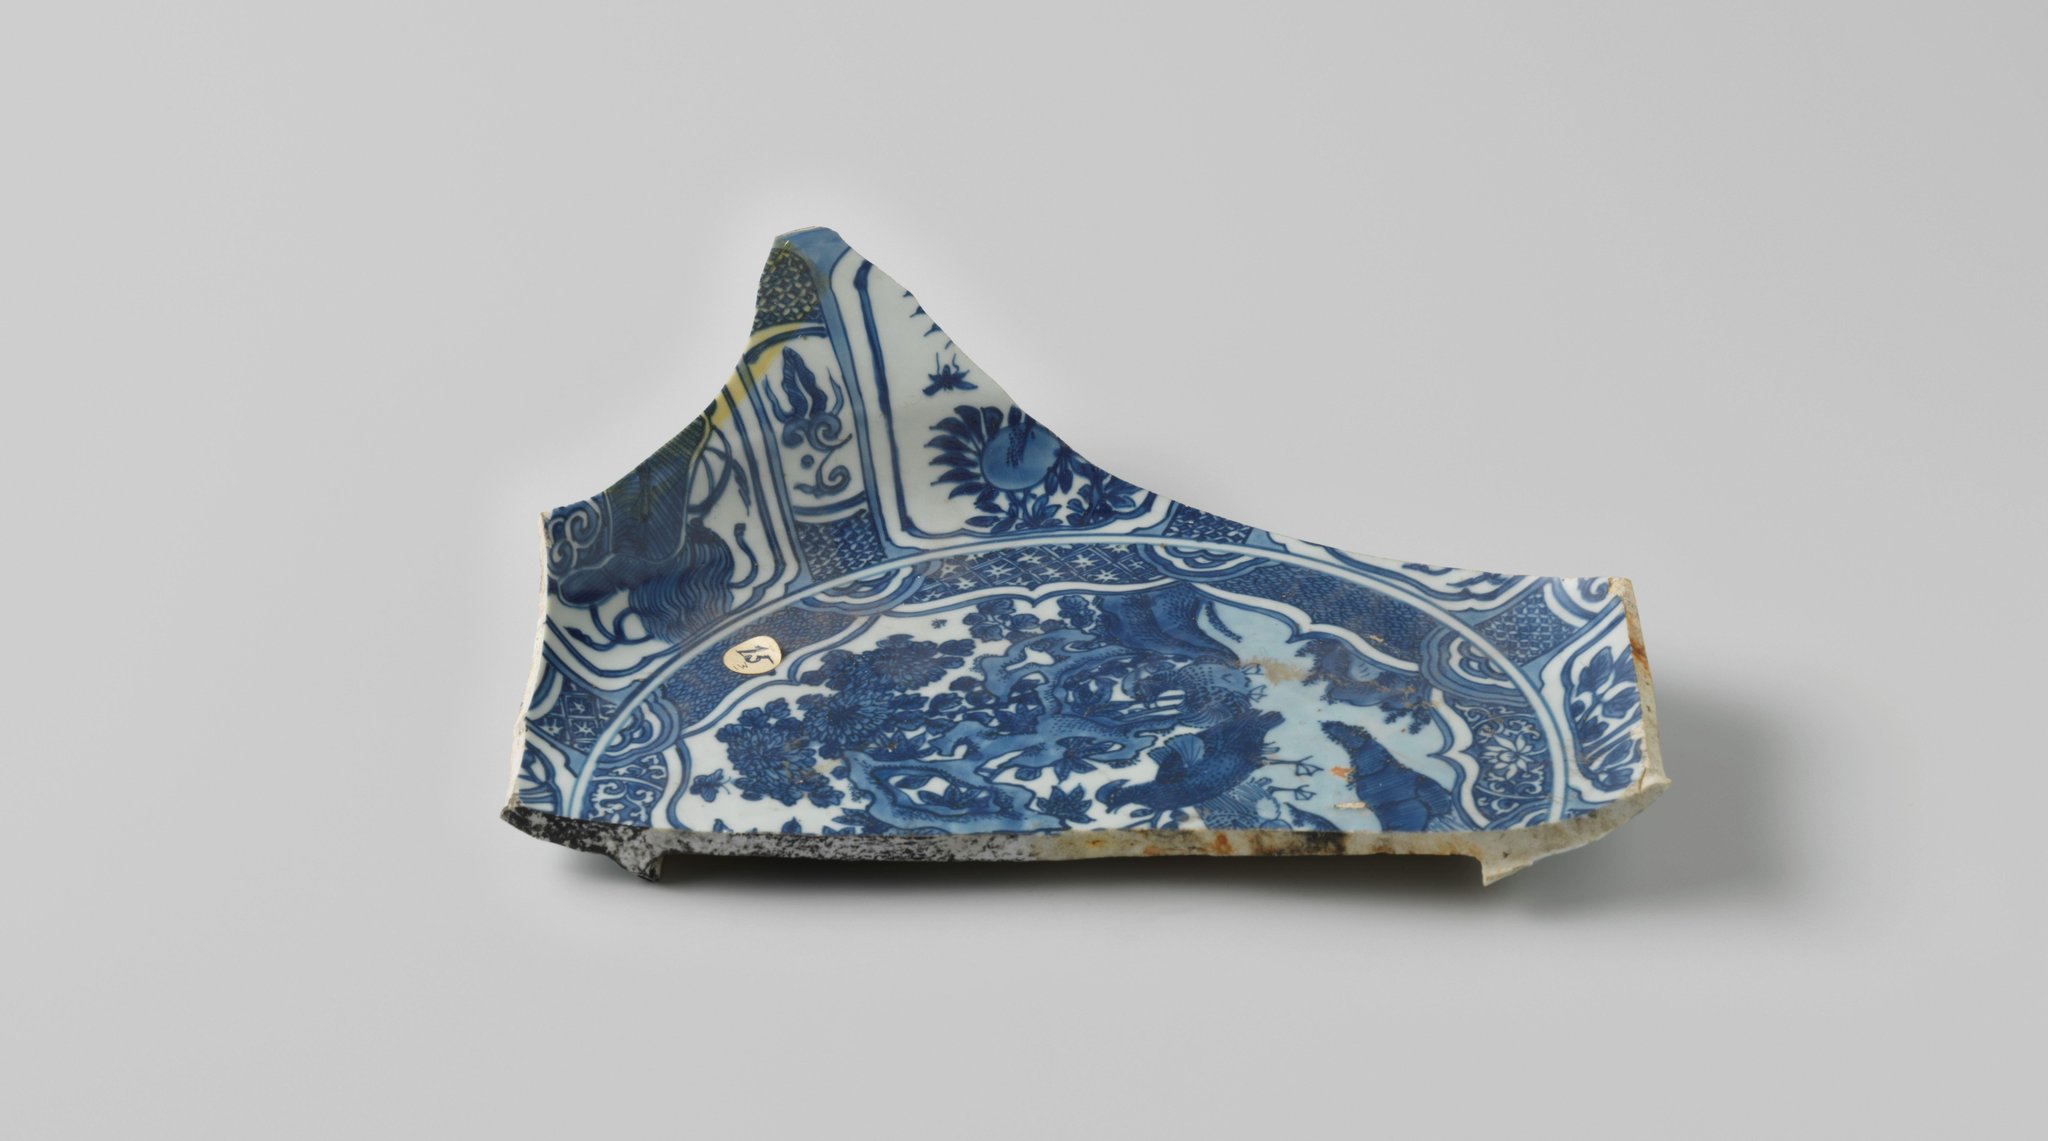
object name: washbowl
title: Fragment schotel uit V.O.C.-schip de 'Witte leeuw'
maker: Anonymous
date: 1613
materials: bone china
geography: jingdezhen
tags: verenigde oostindische compagnie, sint-helena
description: A large plate with a flattened rim. A scalloped medallion with rui heads within concentric bands filled with alternating diaper patterns. A central decoration of two mandarin ducks and a chrysanthemum. Panels decorated with flowers, fruit and symbols.